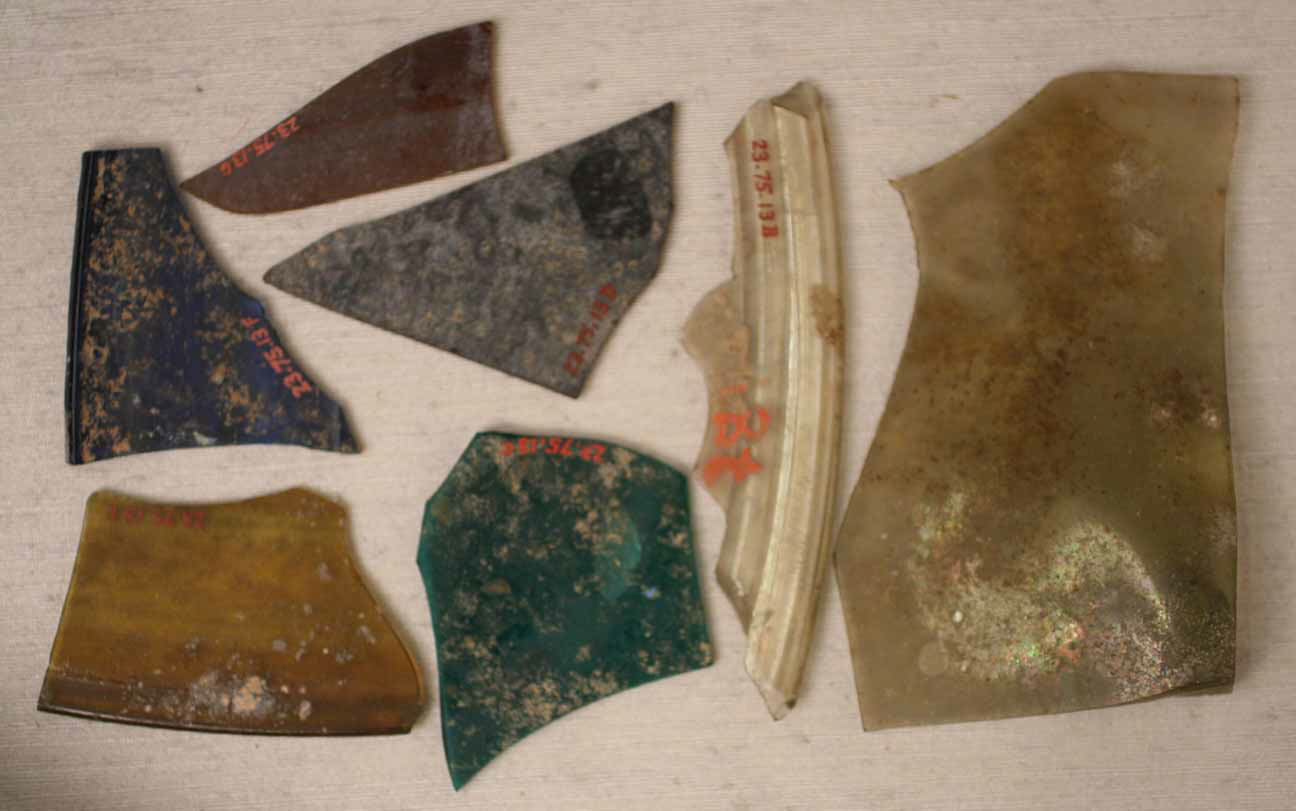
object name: glass fragment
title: Seven Glass Fragments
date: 801-900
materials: glass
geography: iraq